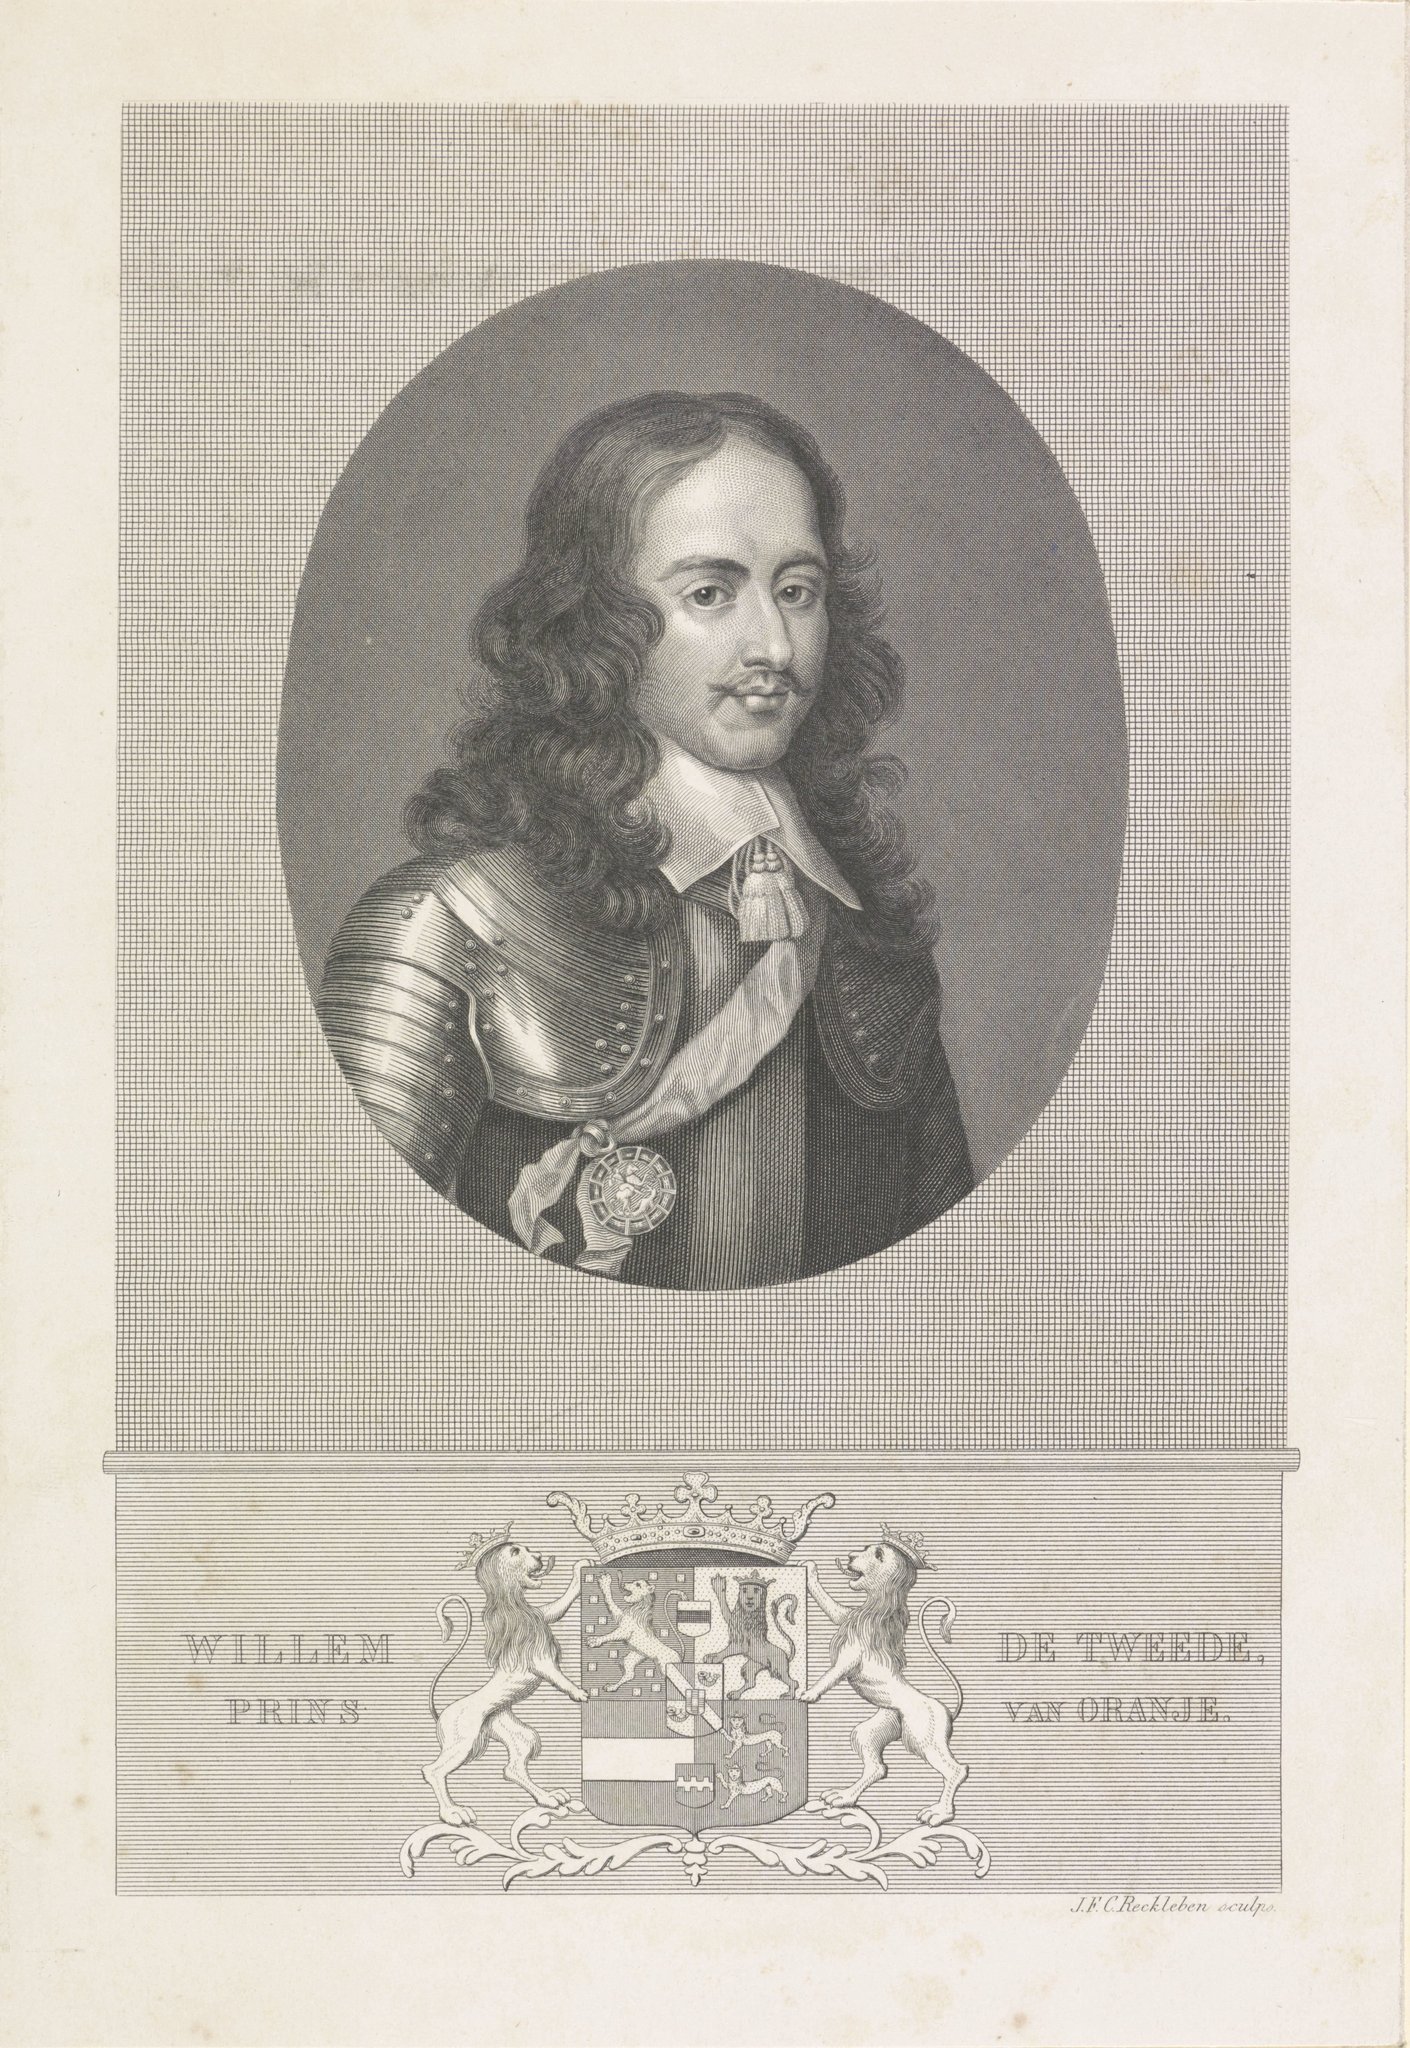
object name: print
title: Portret van Willem II, prins van Oranje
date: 1840-1884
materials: paper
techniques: engraving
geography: amsterdam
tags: william ii (prince of orange), knighthood order (garter) - insignia of a knighthood order, e.g.: badge, chain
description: De hier vermelde titel verwijst naar de hoogst verkregen titel van de geportretteerde, niet per se naar de titel die de geportretteerde op deze voorstelling draagt. Prent uit: Arend, Johannes Pieter. Algemeene geschiedenis des vaderlands van de vroegste tijden tot op heden. Amsterdam: J.F. Schleijer, 1840-1884.